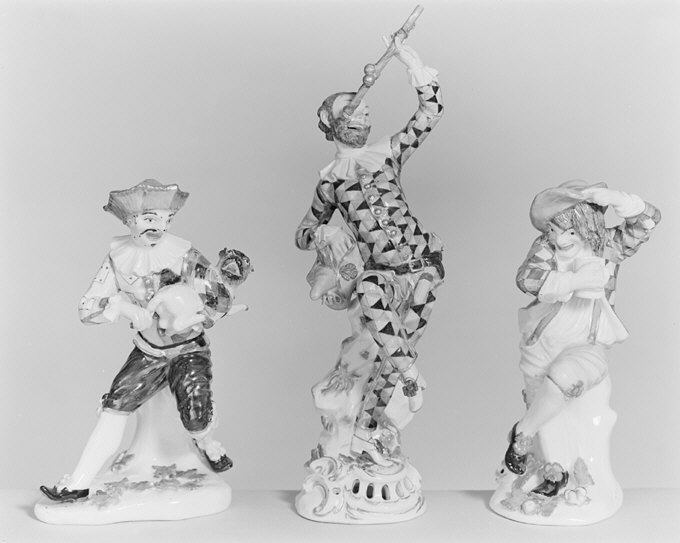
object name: figure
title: Harlequin dancing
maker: meissen manufactory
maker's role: manufactory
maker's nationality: german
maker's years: 1710-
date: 1763-1764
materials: hard paste porcelain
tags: men,dancing